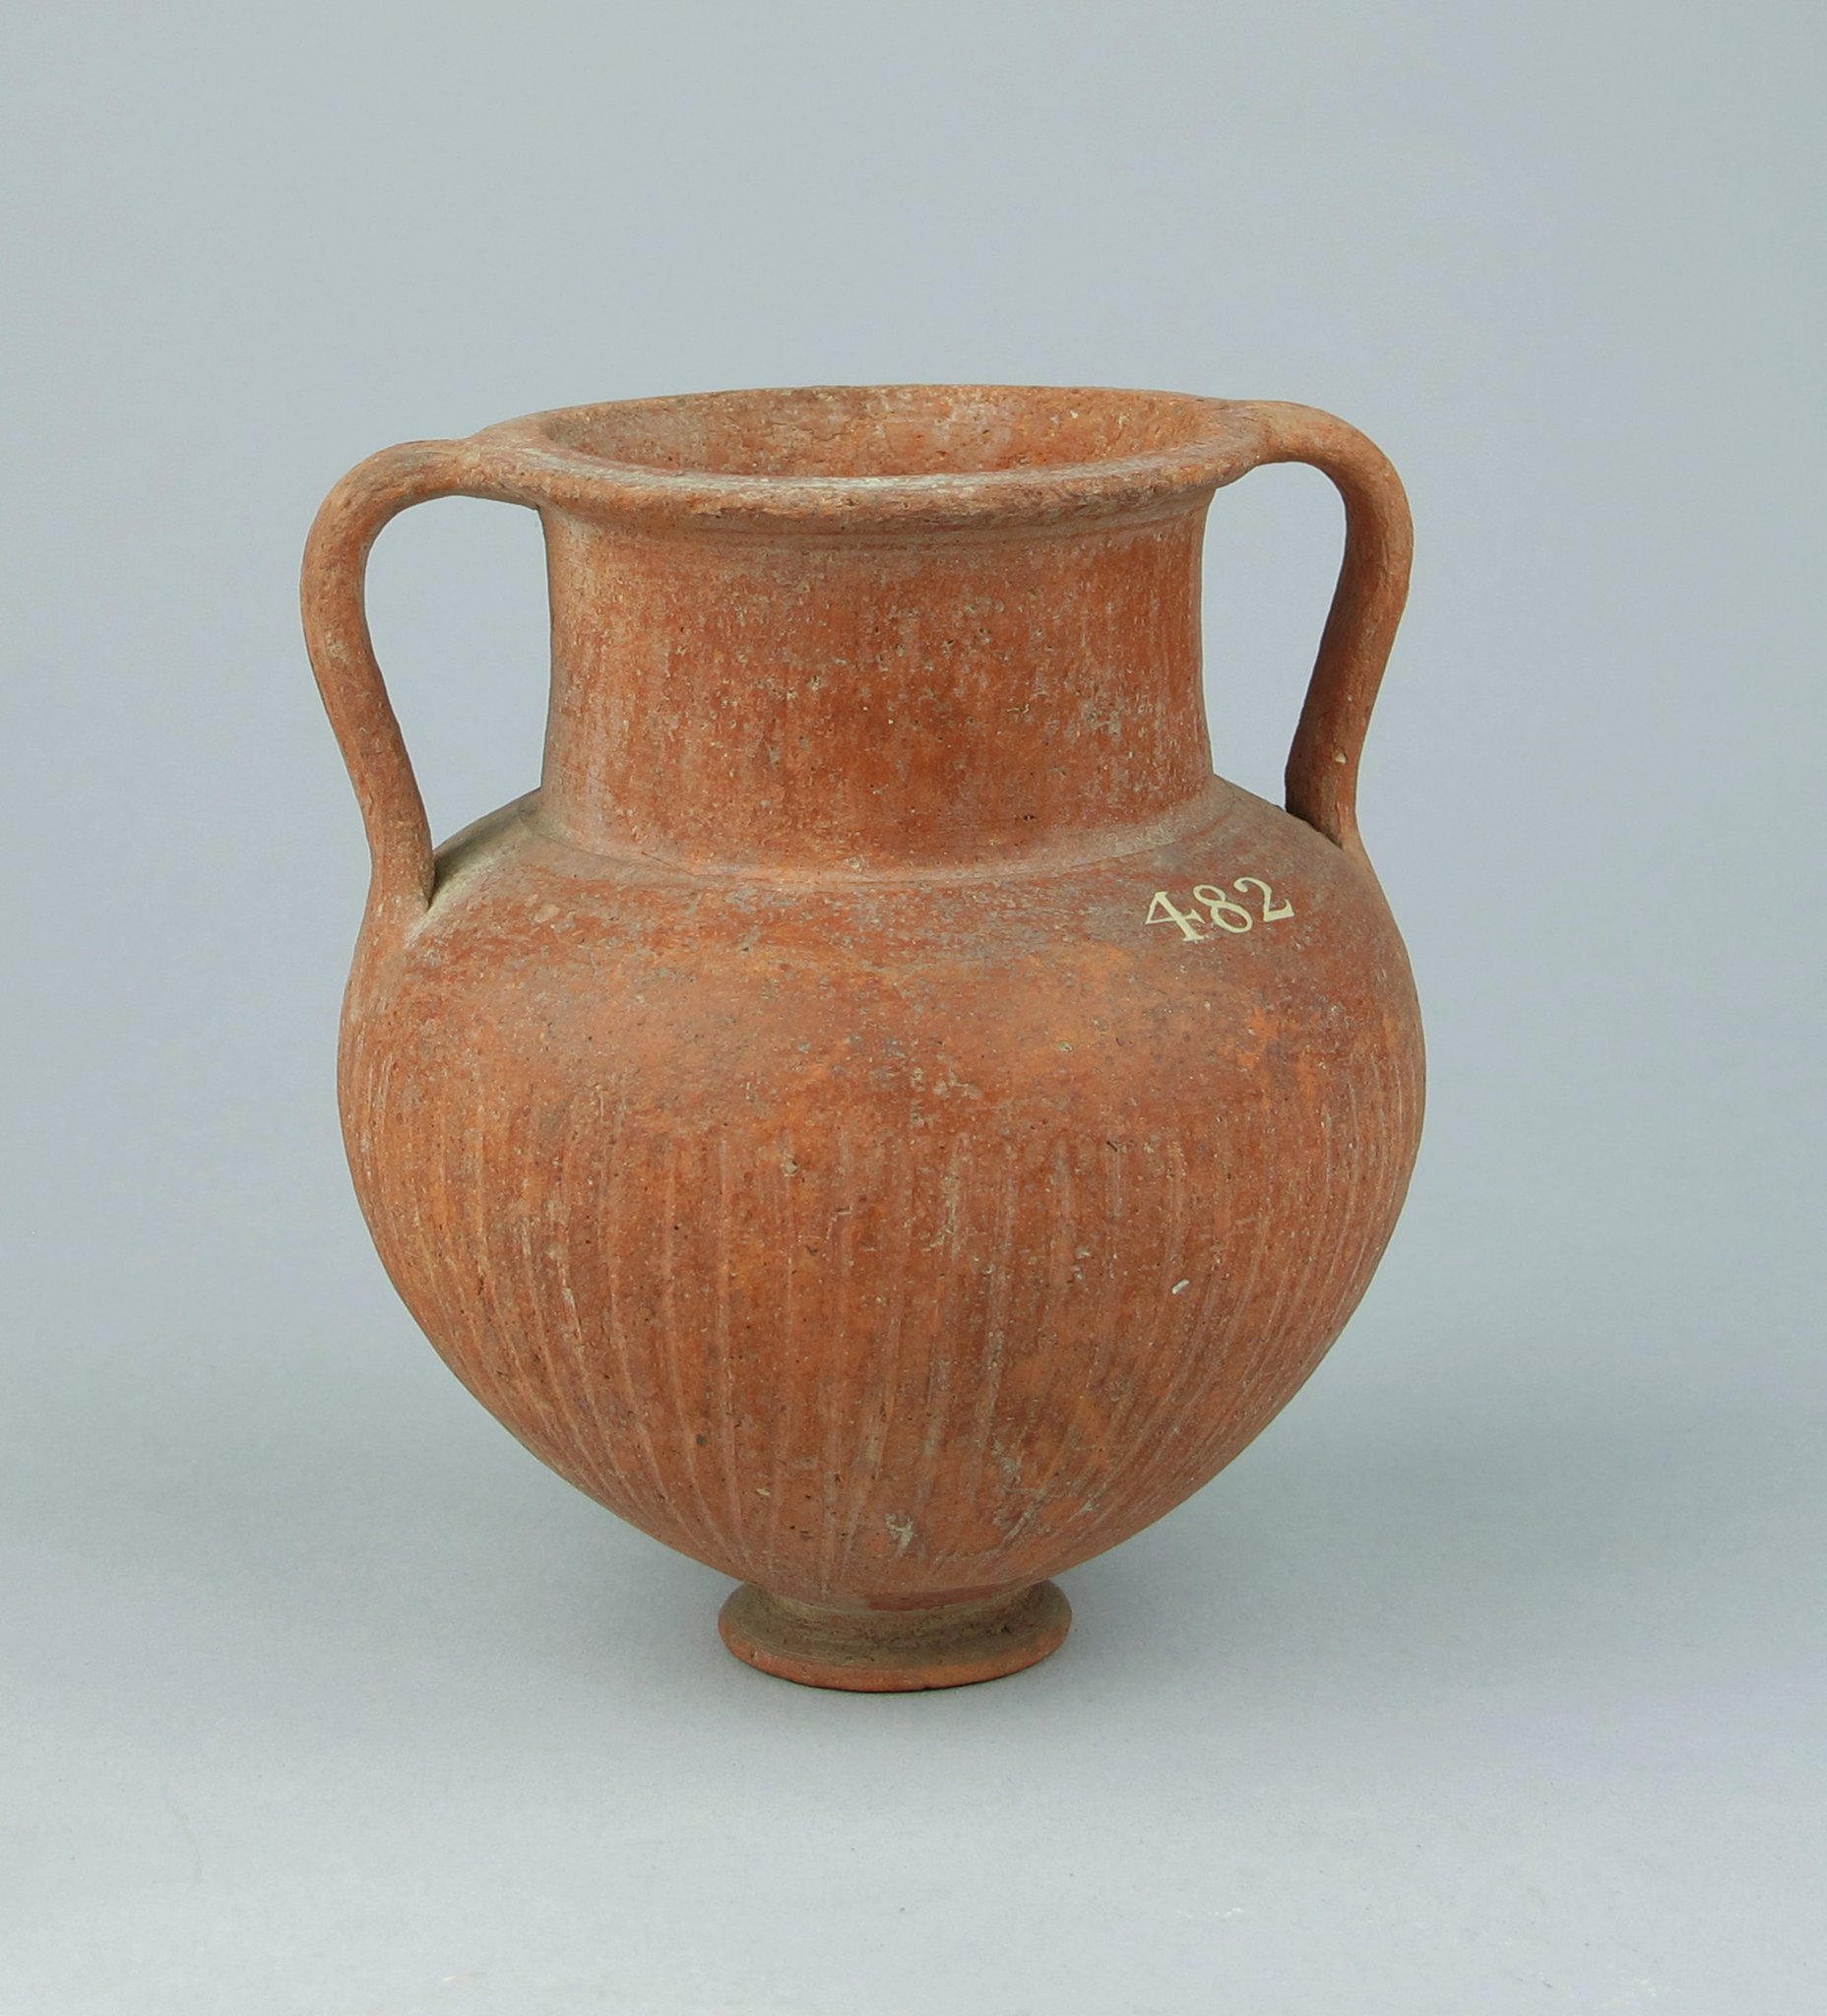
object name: amphoriskos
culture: cypriot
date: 850-700 BCE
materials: terracotta